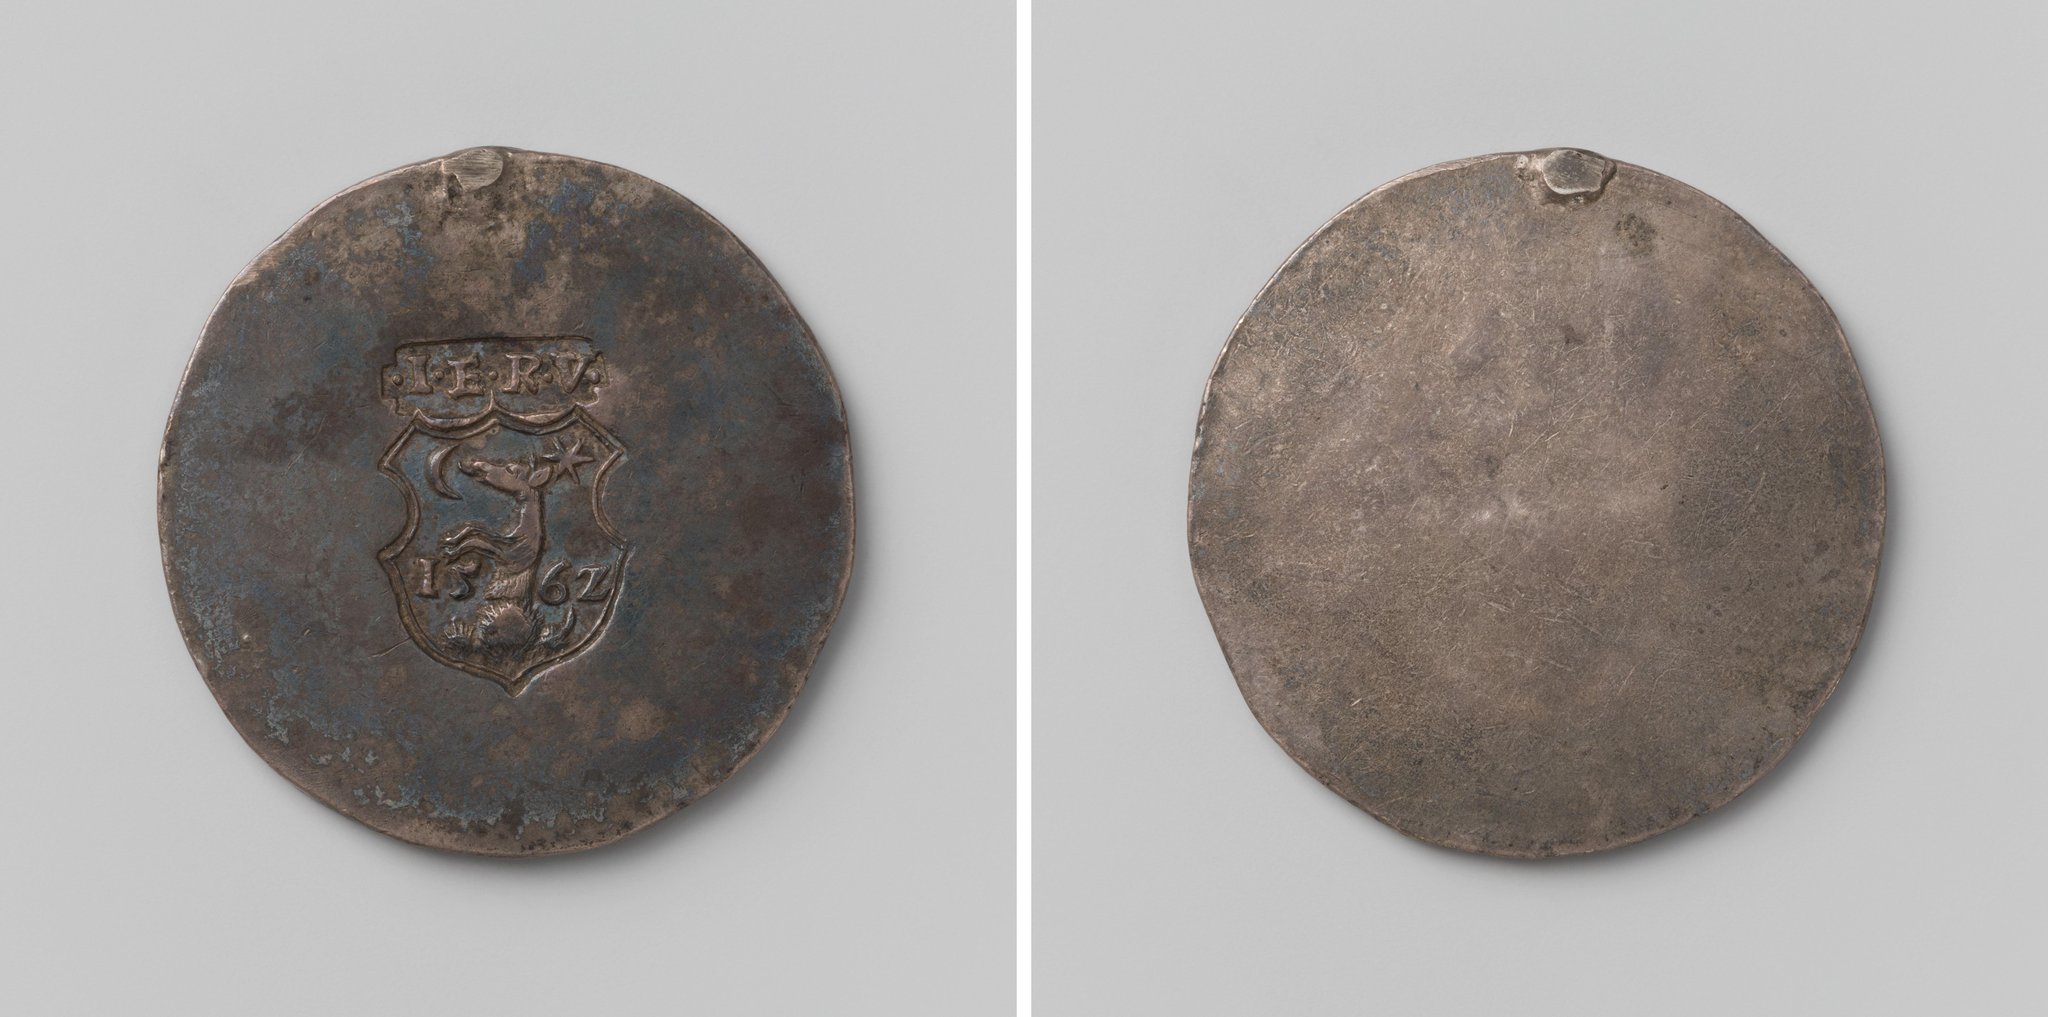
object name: coin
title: Taler, noodmunt voor het leger van Johan II Sigismund Zápolya, troonpretedent van Hongarije en prins van Transsylvanië, in oorlog tegen keizer Ferdinand I.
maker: Anonymous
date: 1562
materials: silver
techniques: striking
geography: hungary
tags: ferdinand i van habsburg (duits keizer)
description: enkelzijdige noodmunt met afgebroken draagoog of opgevuld gat. Voorzijde: twee stempels: bovenste stempel: letters I, E, R en V in compartiment; onderste stempel: in cartouche: staand dier ten halven lijve tussen maan en ster en jaartal. Keerzijde: blanco